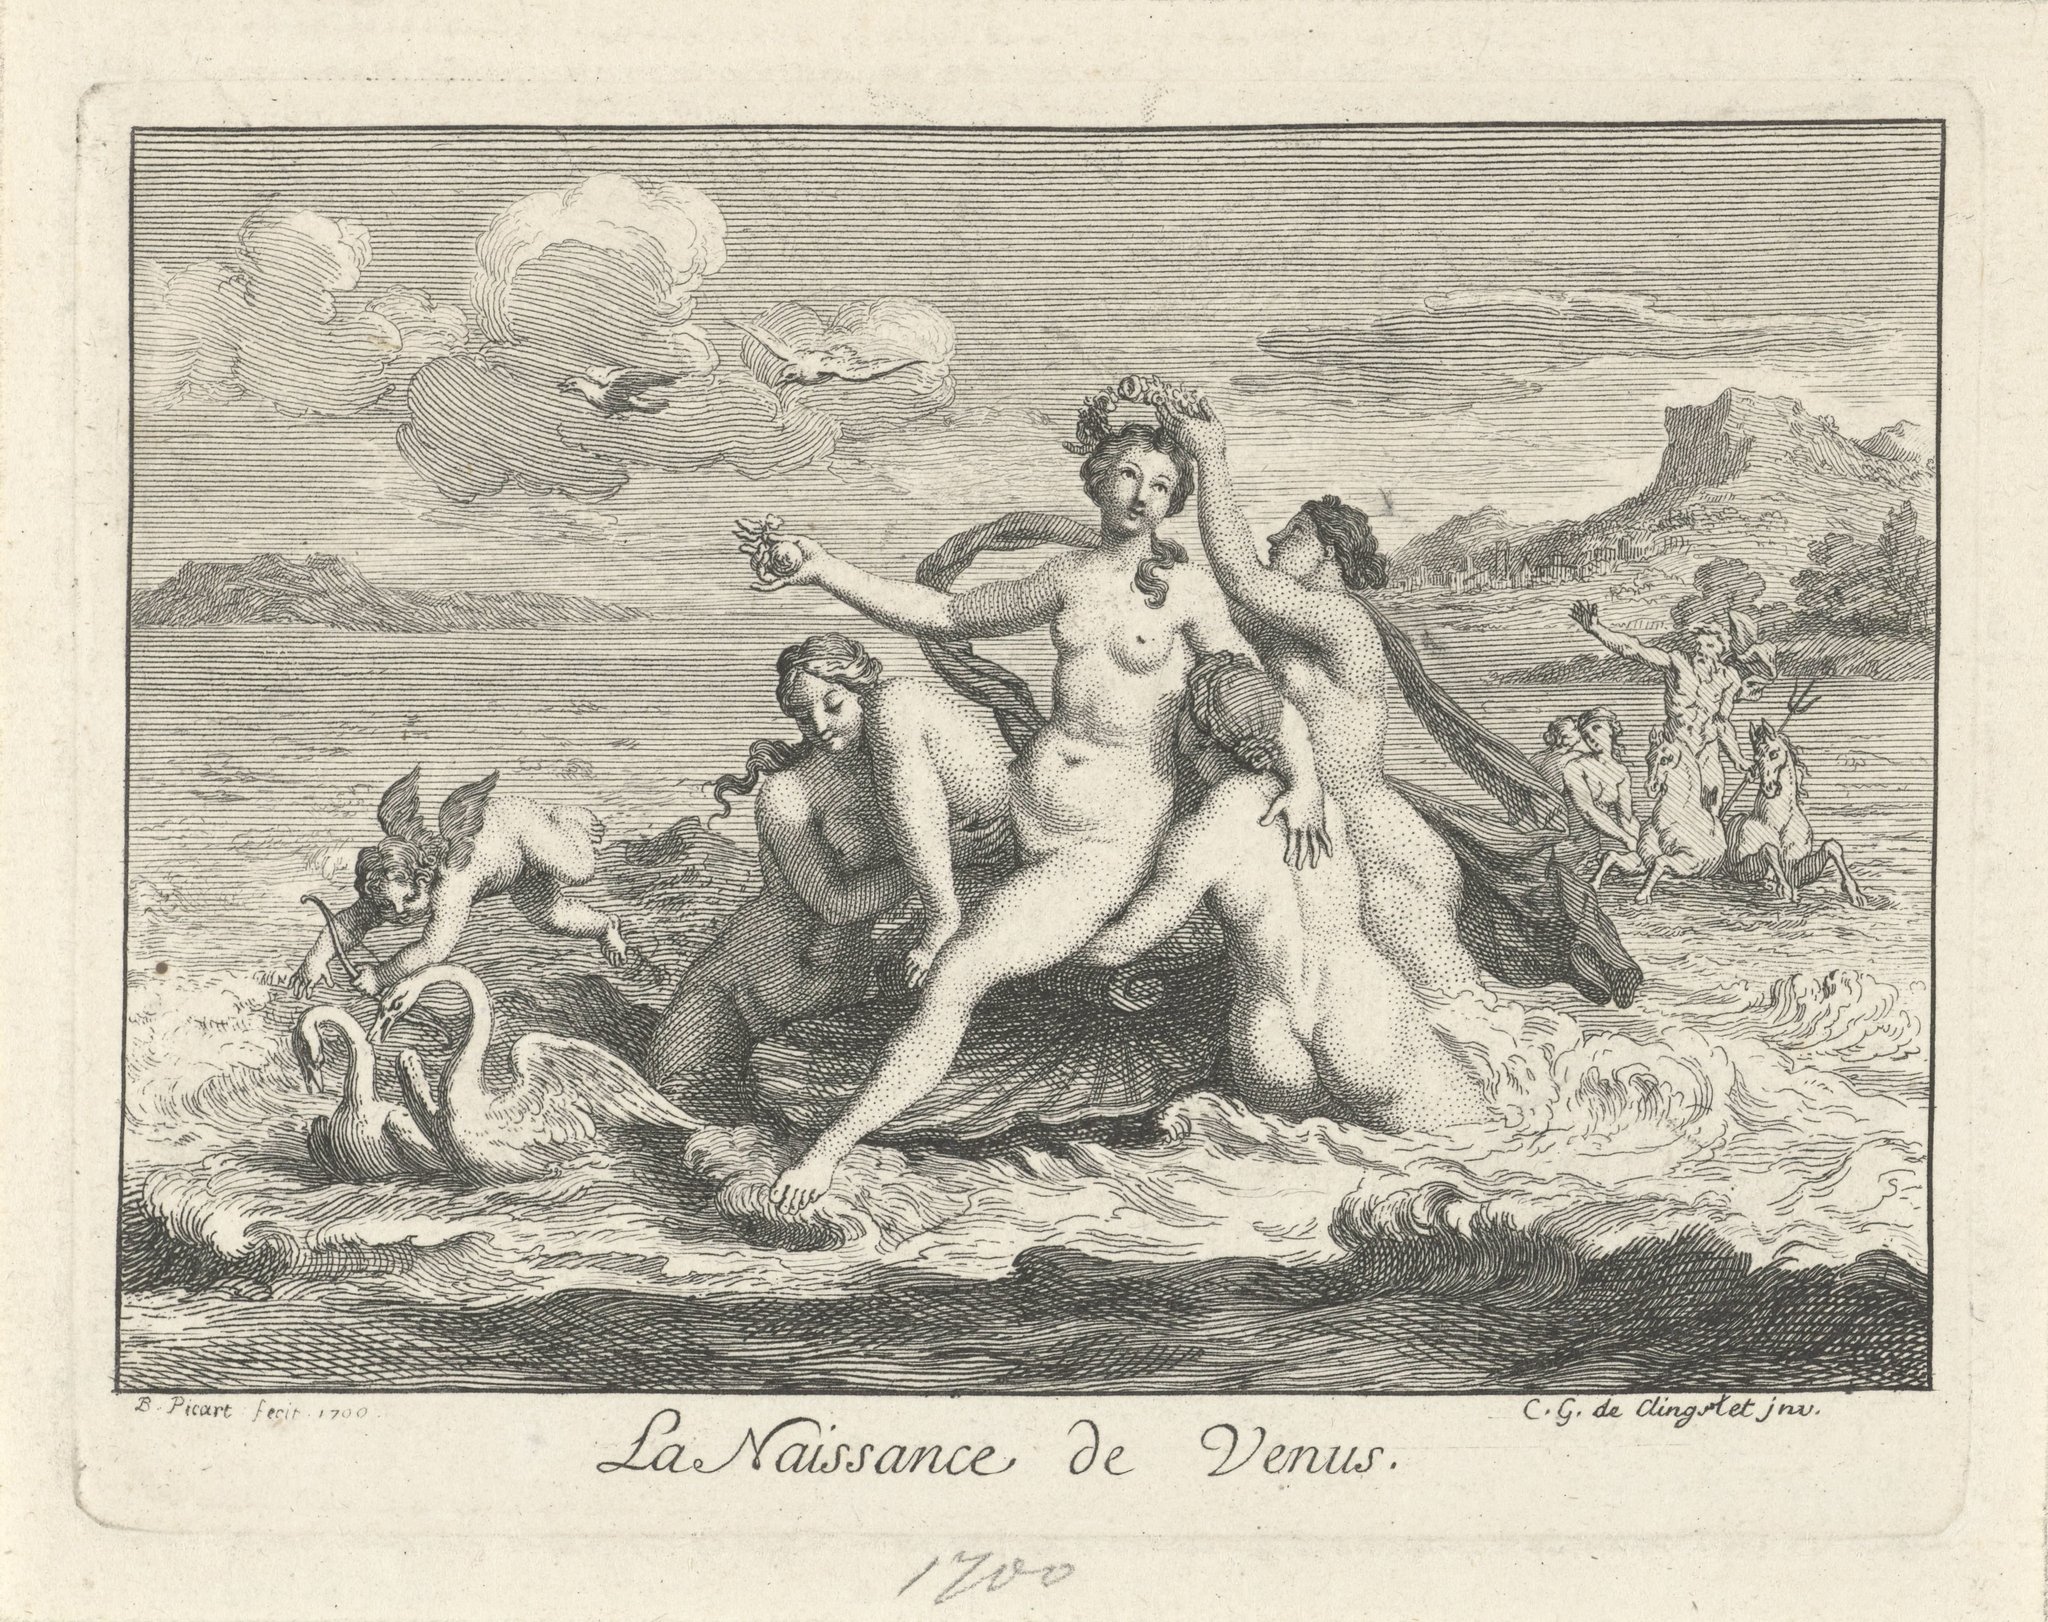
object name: print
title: La Naissance de Venus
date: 1700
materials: paper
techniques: engraving, etching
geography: paris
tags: (story of) neptune (poseidon), birth of venus; venus anadyomene: after uranus' castration venus rises from the sea wringing the water from her hair; usually she is awaited by the hours, (story of) cupid, amor (eros)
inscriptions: collector's mark: Lugt 240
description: Venus drijft naar de kust op een schelp, voortgetrokken door zwanen, met een appel in de hand. Amor vliegt met hen mee. Waternimfen kronen haar met een bloemenkrans. Op de achtergrond Neptunus op zijn wagen.